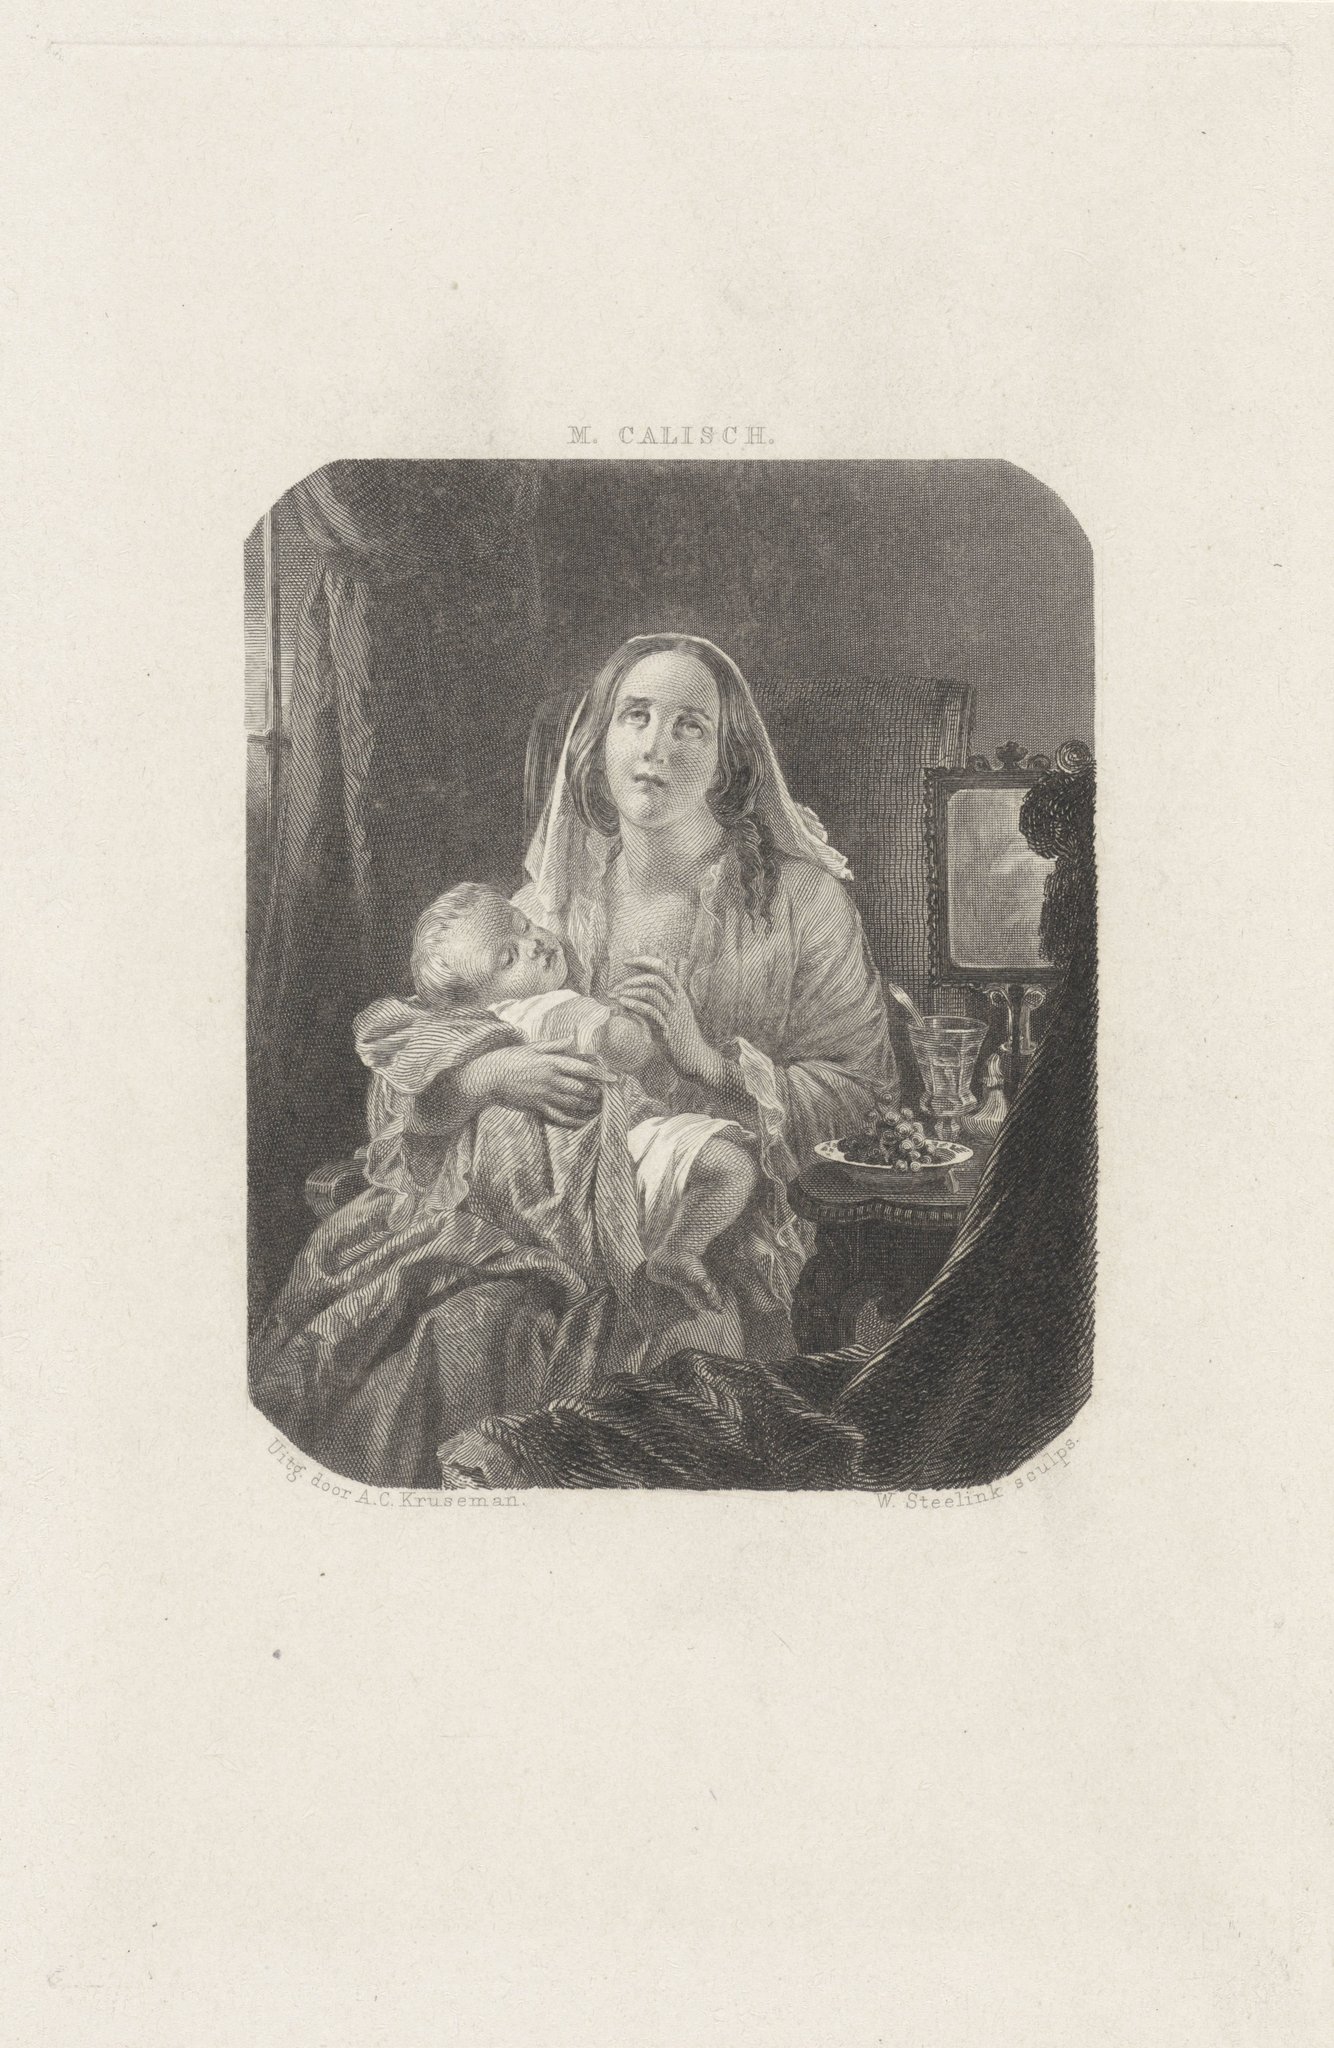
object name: print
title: Moeder met kind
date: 1836-1911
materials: paper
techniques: etching, engraving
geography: amsterdam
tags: mother and baby or young child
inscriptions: collector's mark: Lugt 2228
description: Interieur met een moeder met haar baby op schoot. Zij zitten naast een tafeltje met daarop een spiegel en een schaal met druiven.